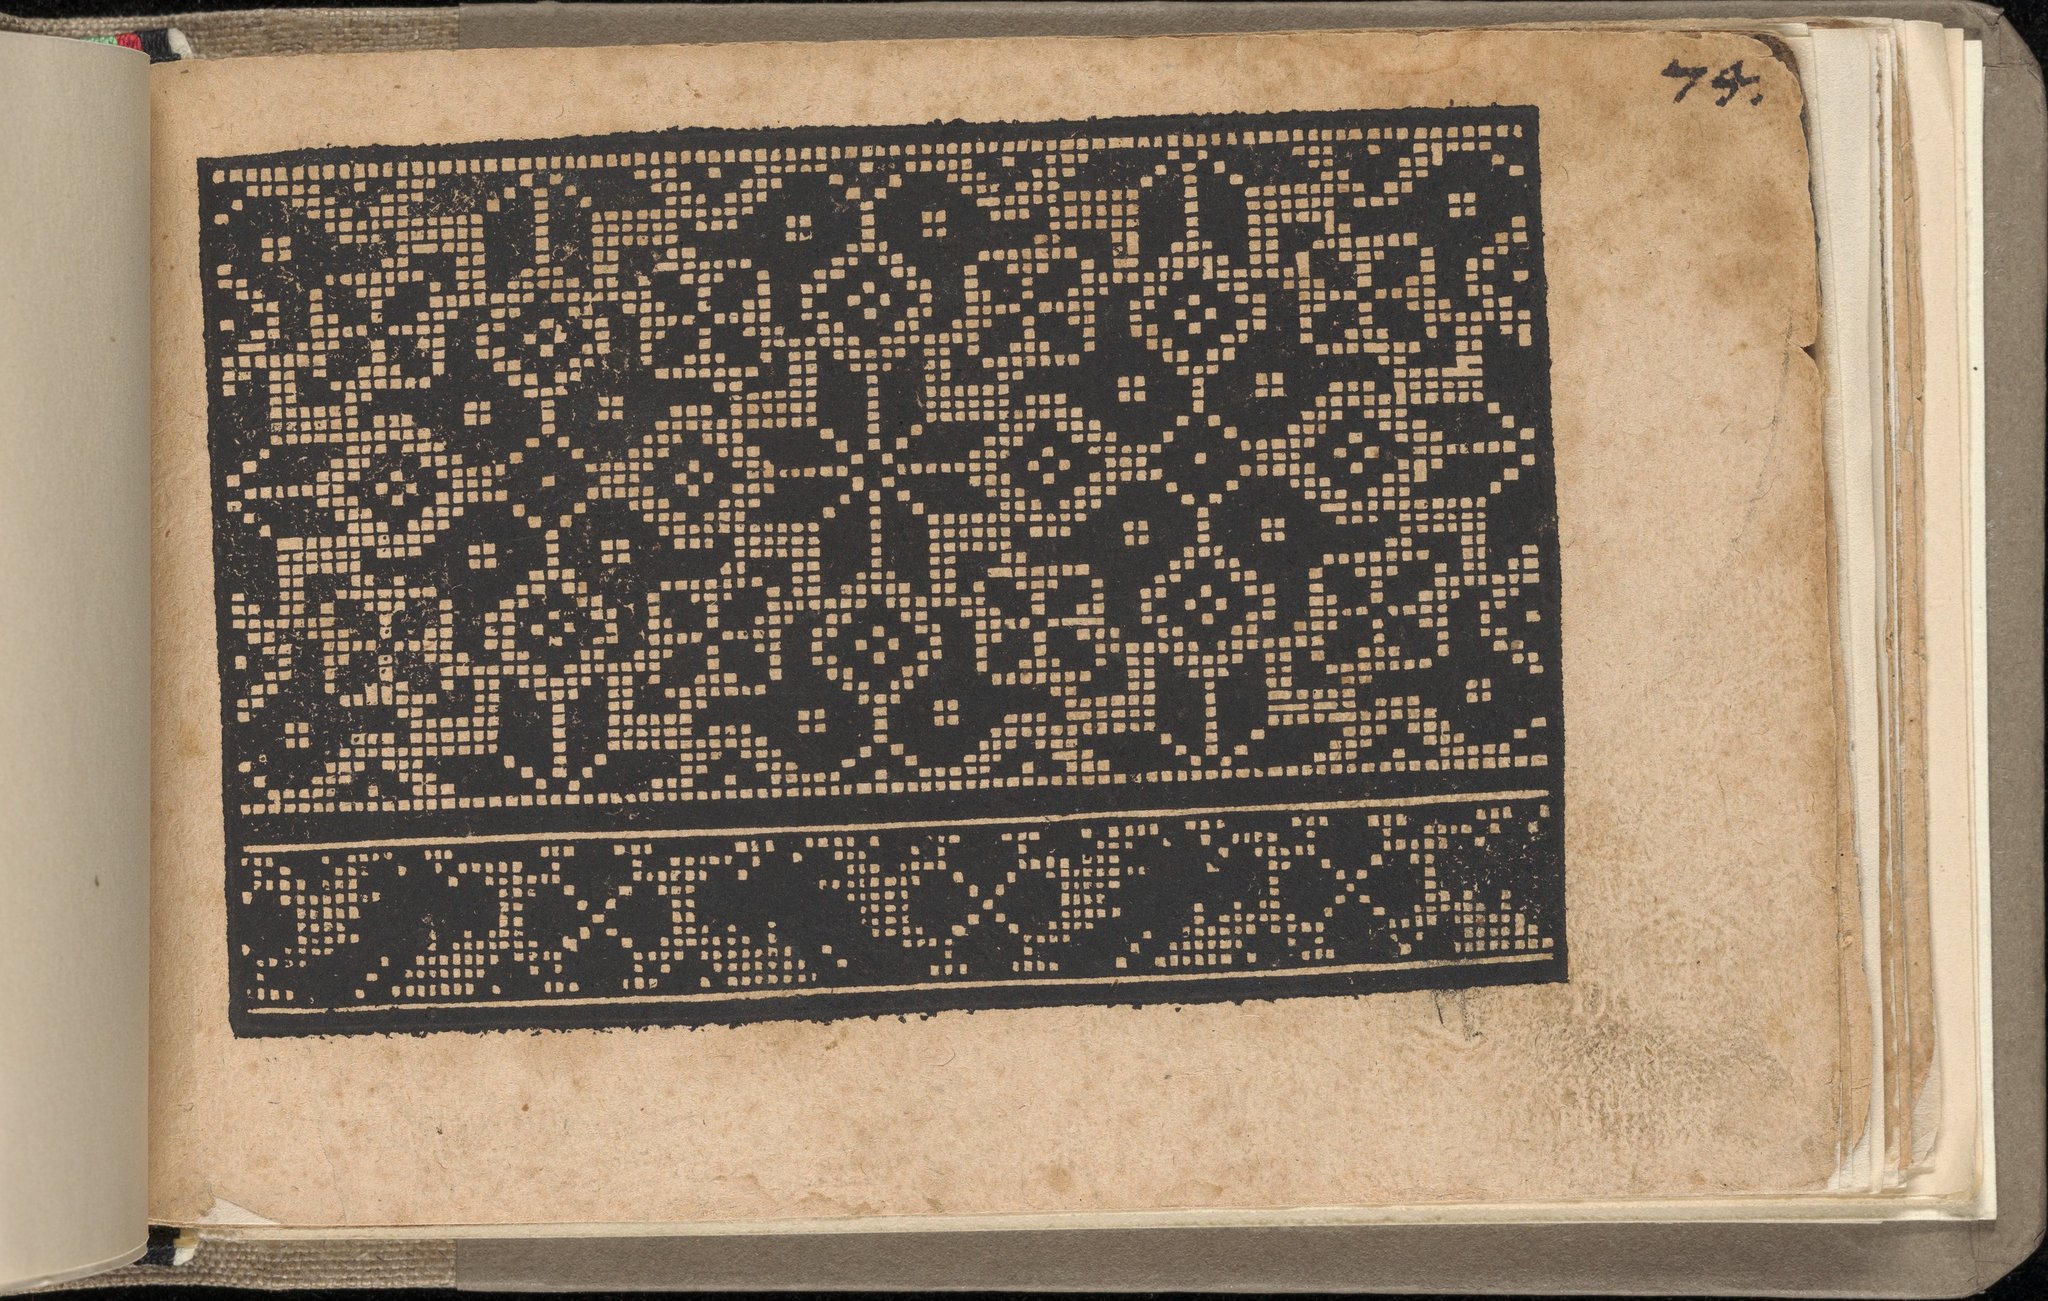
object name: book print ornament architecture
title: Schön newes Modelbuch (Page 74r)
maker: sigismundus latomus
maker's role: publisher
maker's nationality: german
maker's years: 1599-1632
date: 1608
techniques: woodcut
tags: flowers